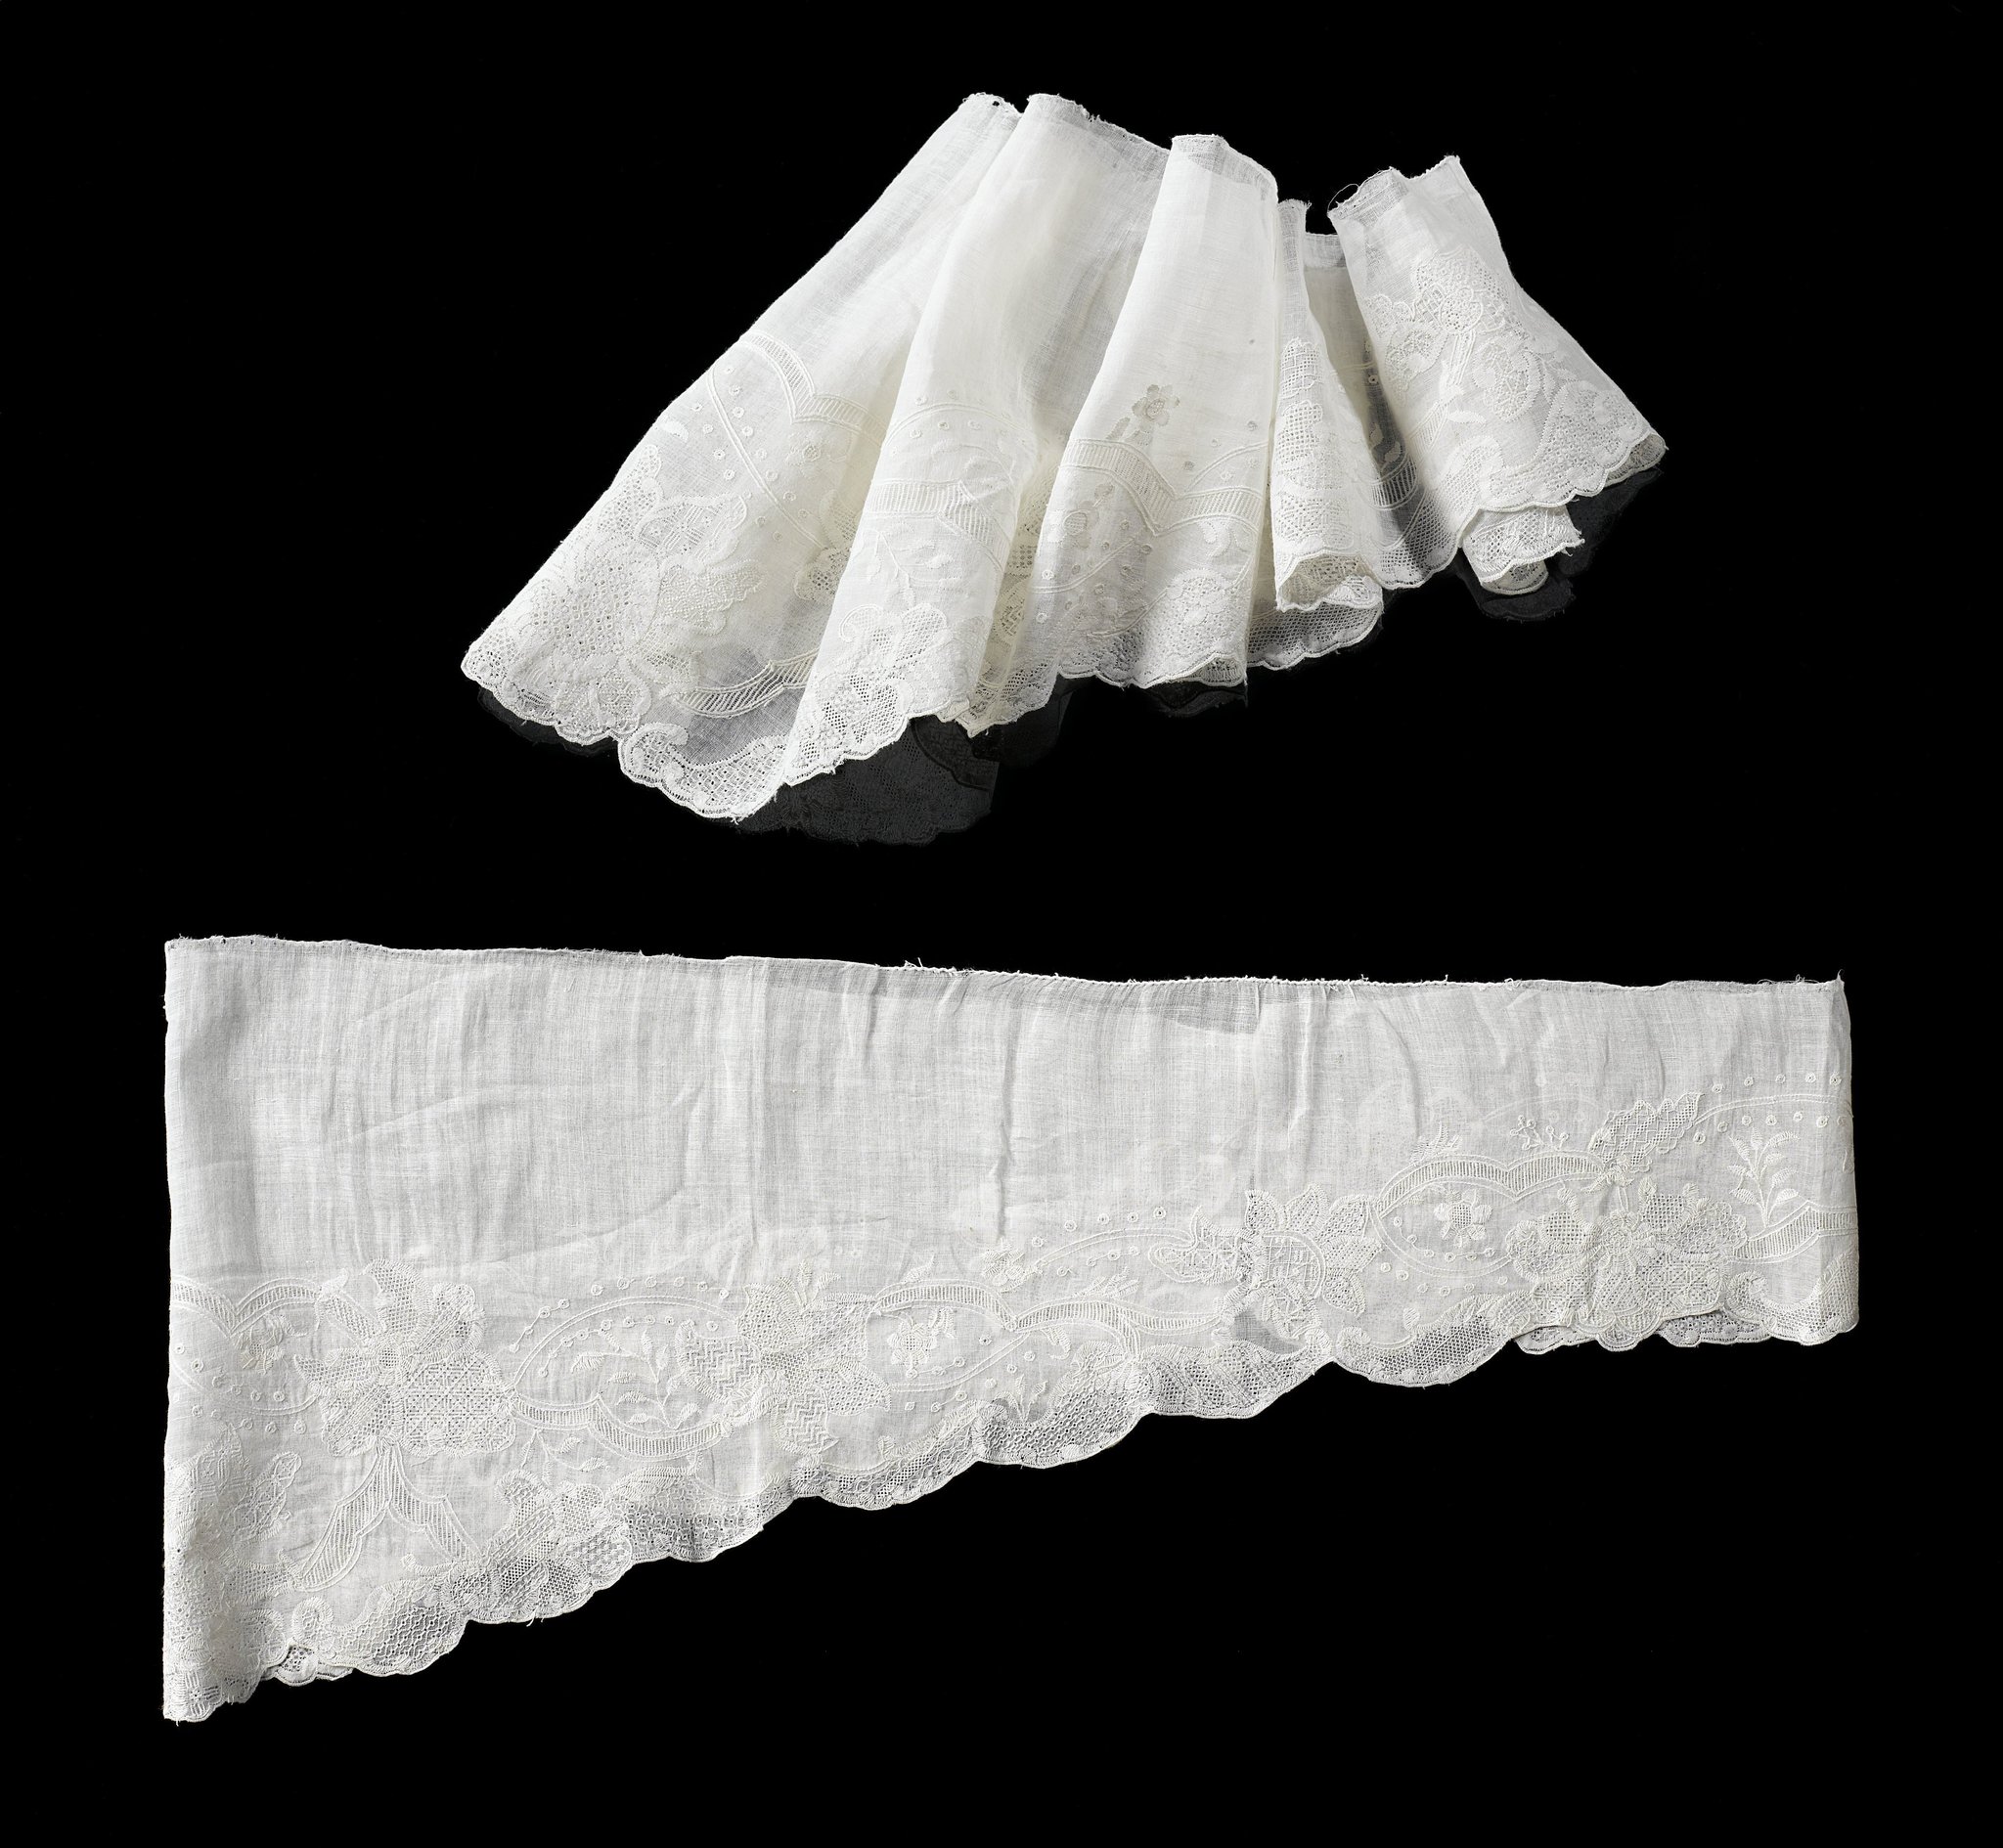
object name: engageante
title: Engageante van dunne katoen (mul), langs de geschulpte rand voorzien van floraal motief in borduur-, schaduwwerk en naaldkant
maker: Anonymous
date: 1750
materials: cotton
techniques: embroidered, weave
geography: netherlands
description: Engageante van dunne katoen (mul), langs de geschulpte rand voorzien van floraal motief in borduur-, schaduwwerk en naaldkant. Versiering: fils tirés en schaduwwerk. Het patroon bestaat uit palmetbloemen en een rivière.